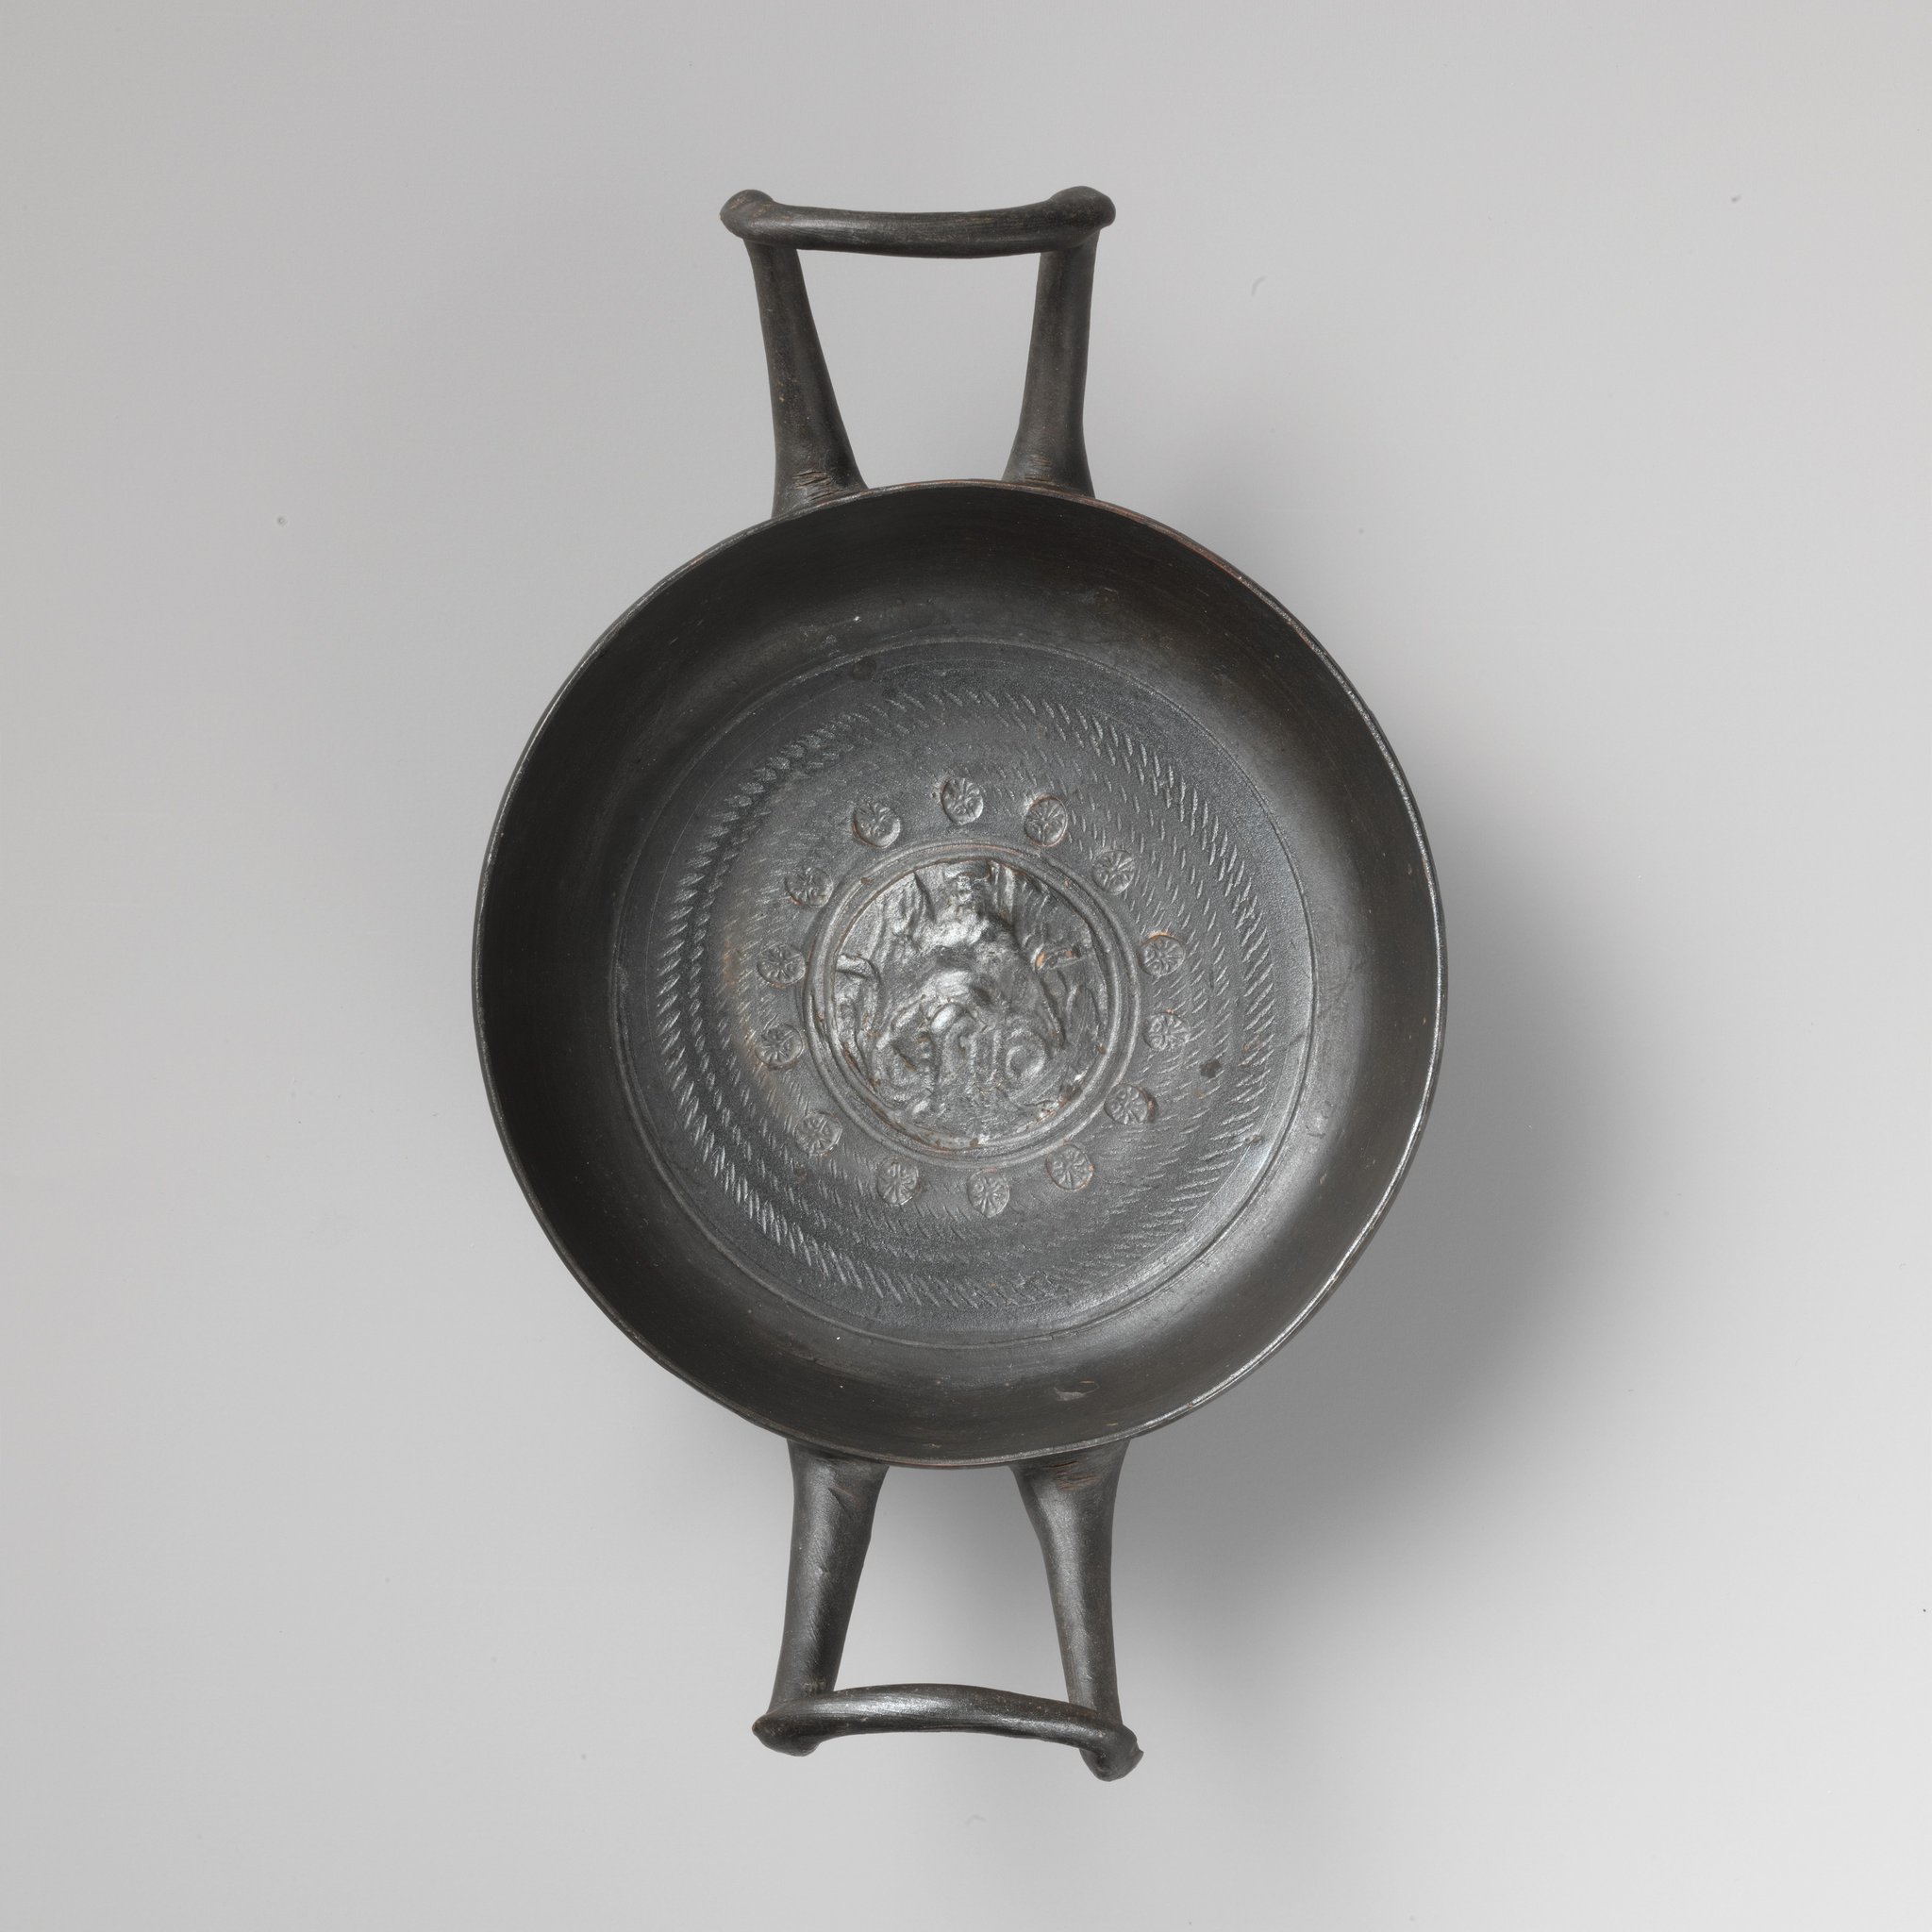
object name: kylix, stemless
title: Terracotta stemless kylix (drinking cup)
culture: greek, calenian or campanian or south italian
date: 334-201 BCE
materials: terracotta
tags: men